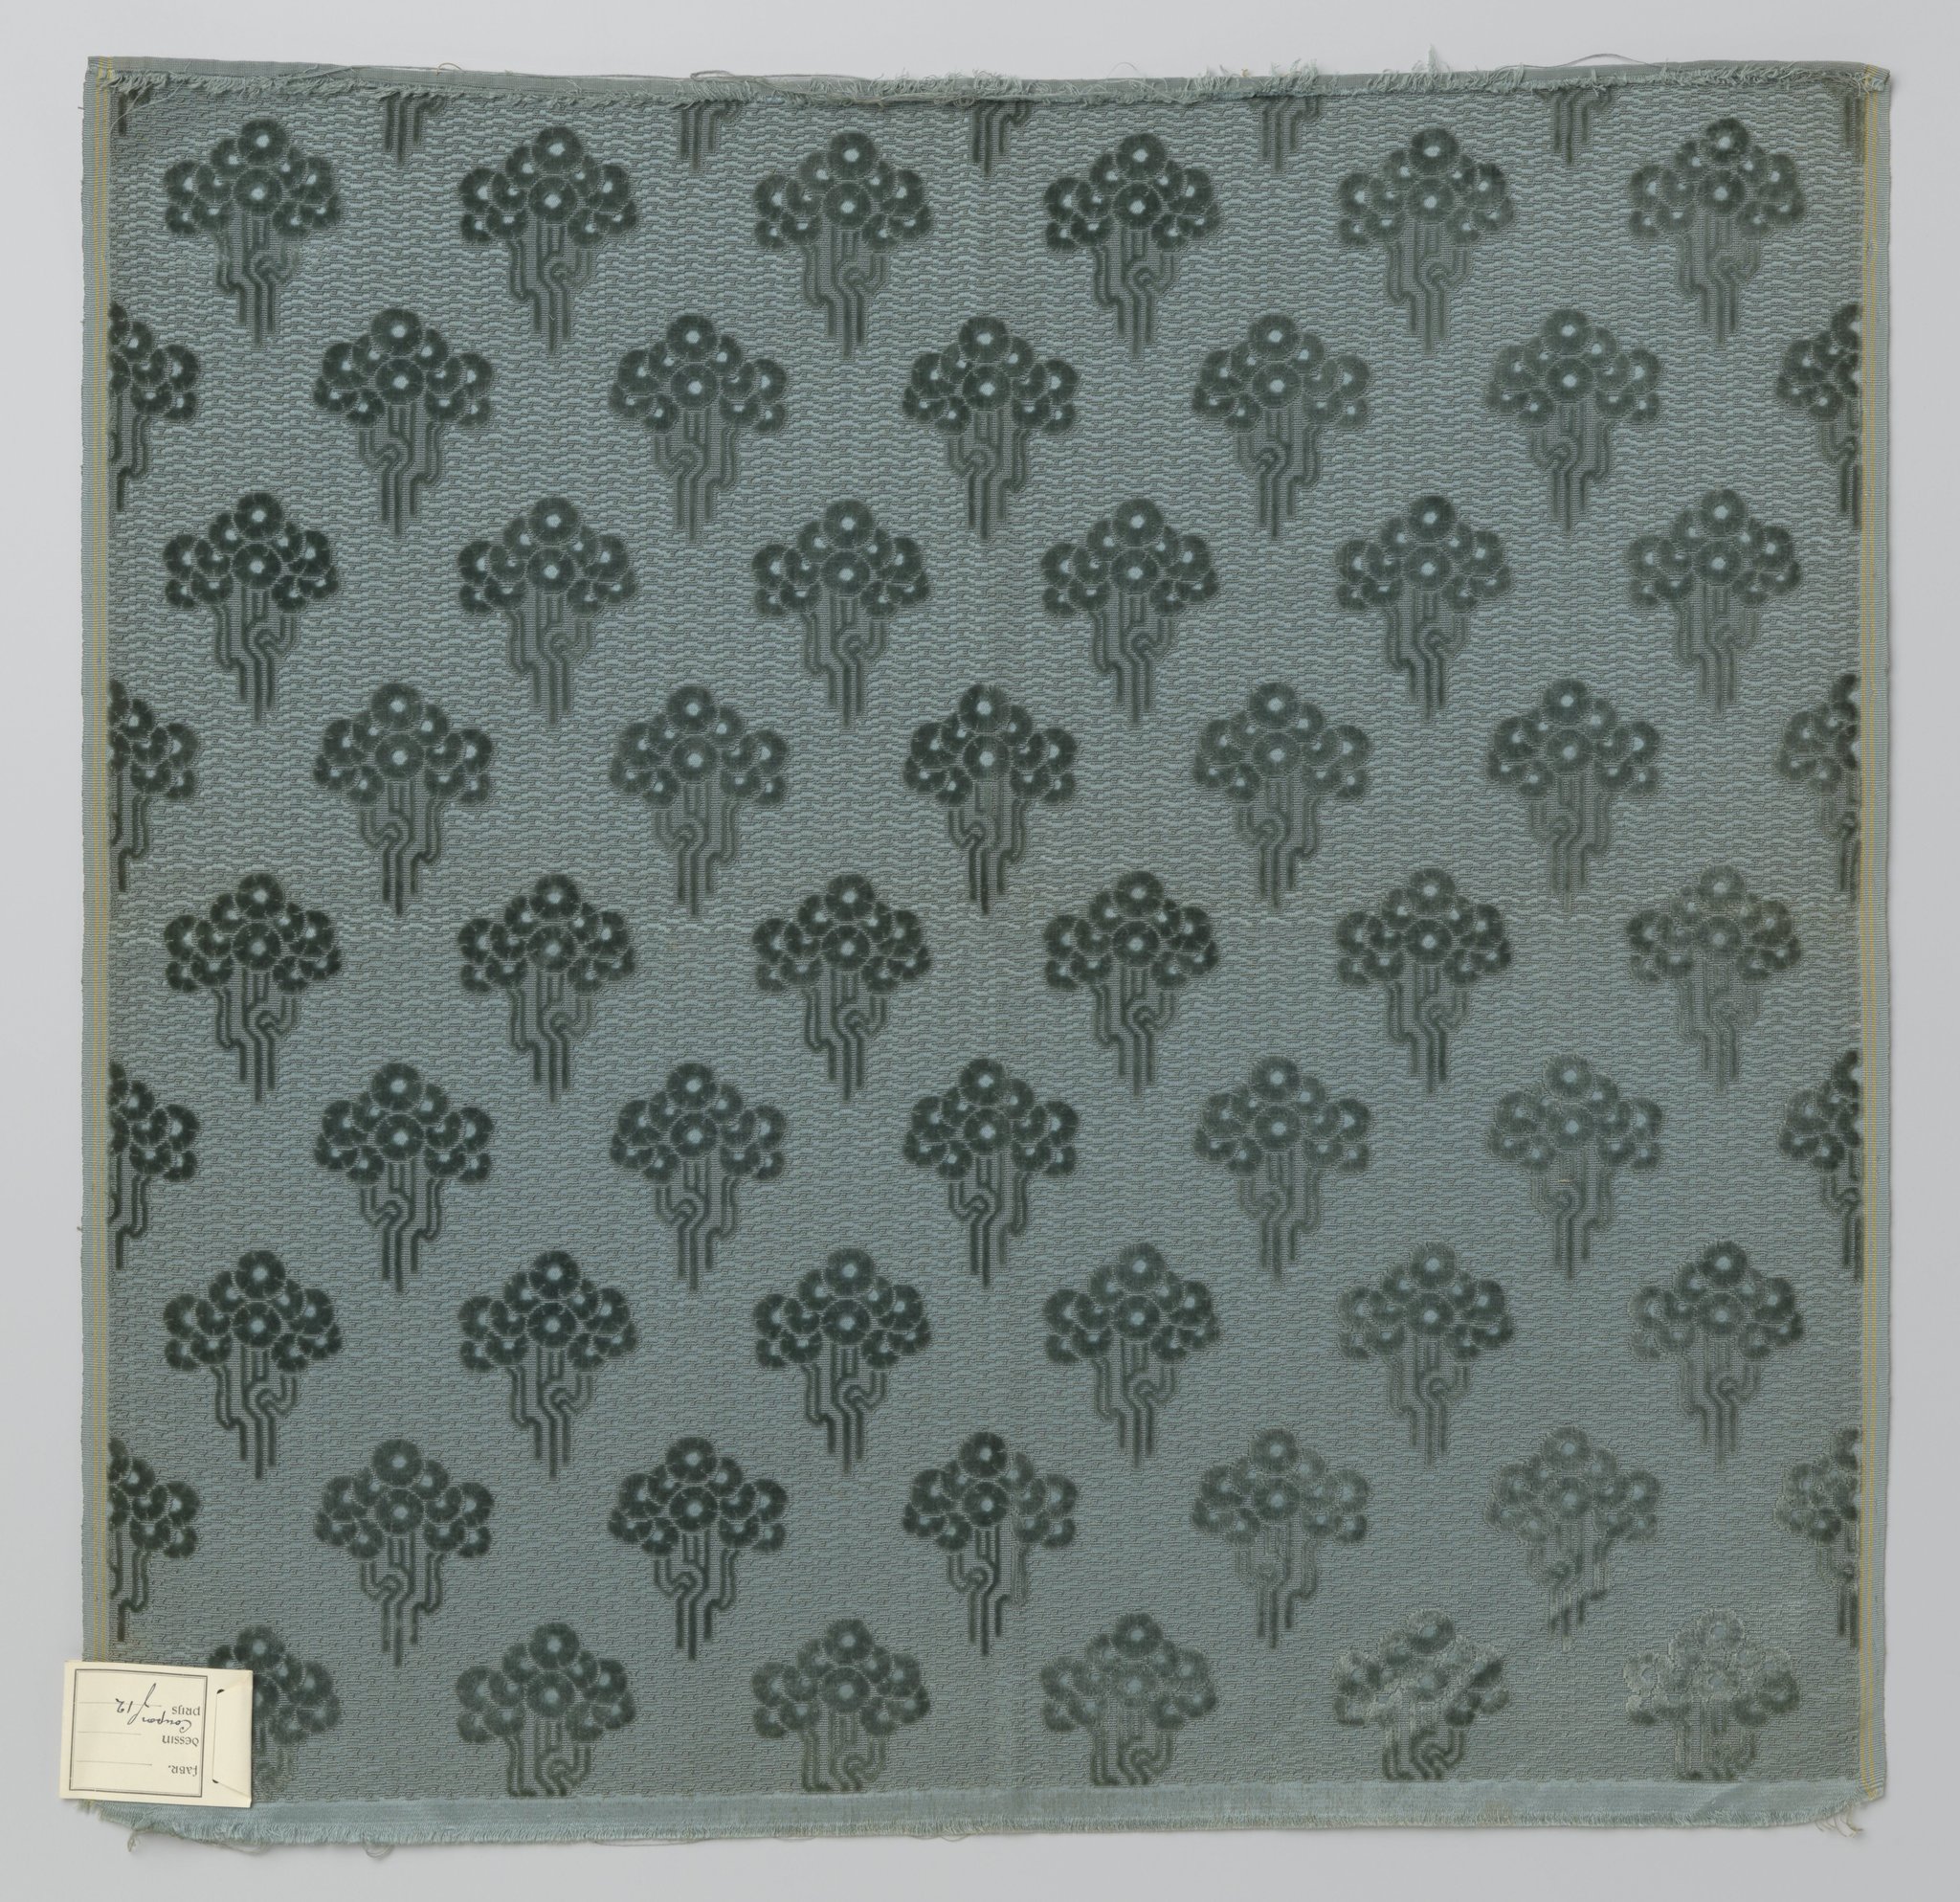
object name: bekledingsstof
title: Genopte en gesneden fluweel met gestileerde bloemtuiltjes, in lichtgroenig-blauw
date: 1920-1930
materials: silk, velvet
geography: the hague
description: Bekledings- of bespanningsstof van genopte en gesneden fluweel met gestileerde bloemtuiltjes, in lichtgroenig-blauw.